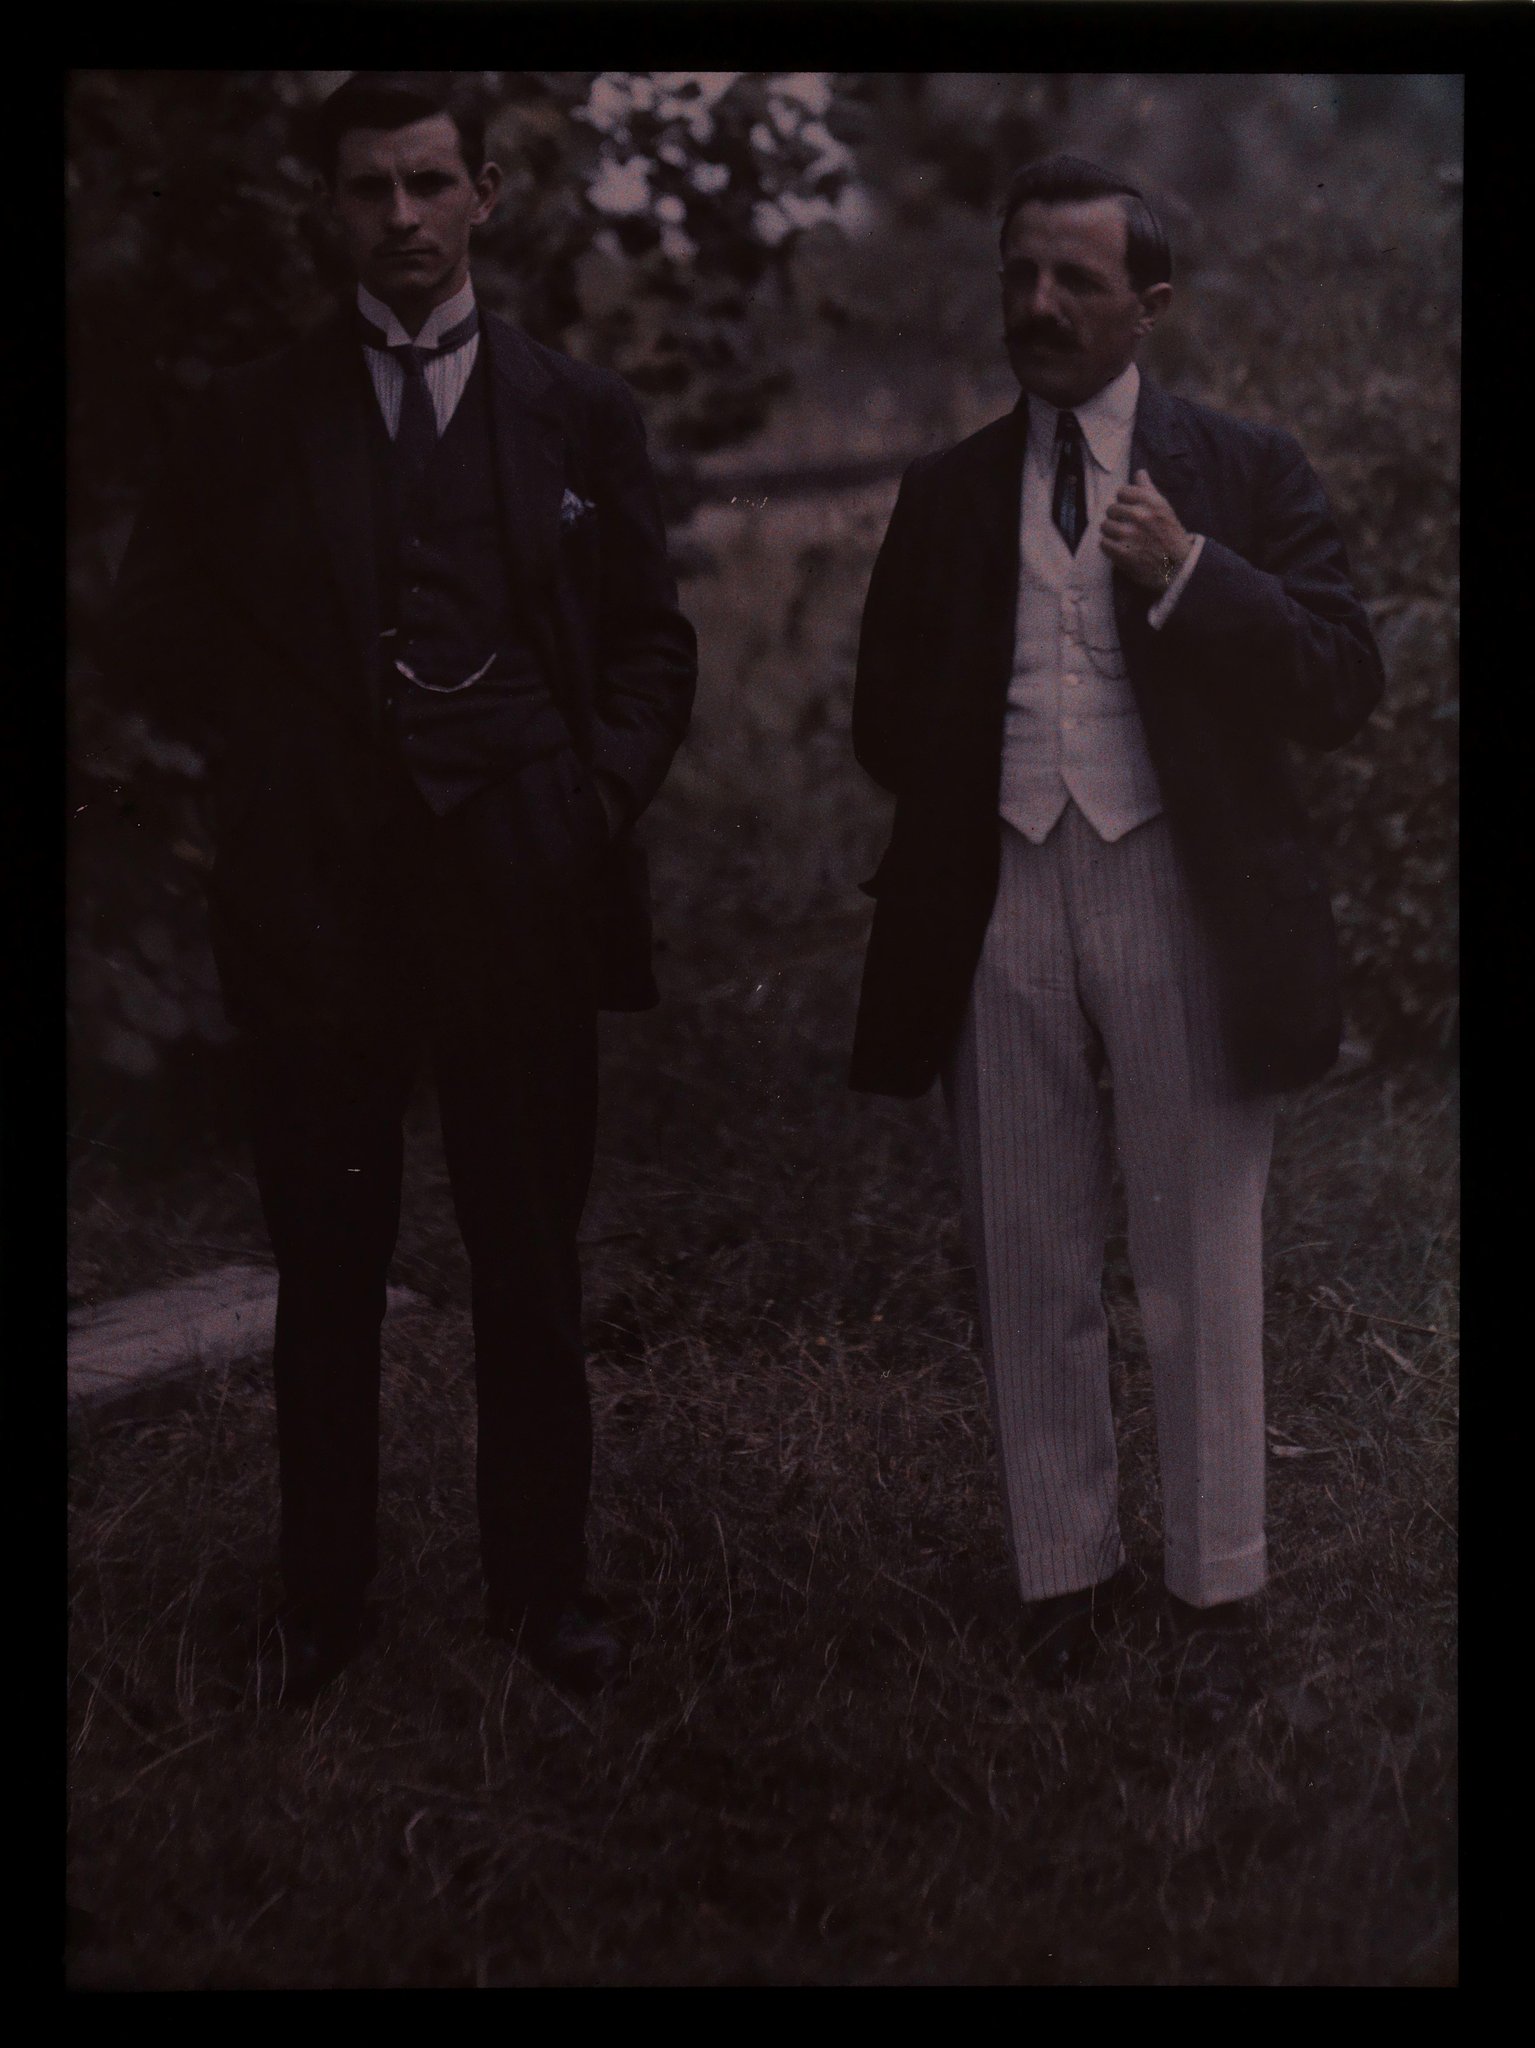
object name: photograph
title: Twee mannen ten voeten uit, gefotografeerd in de natuur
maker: Anonymous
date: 1910-1940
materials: glass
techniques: autochrome process